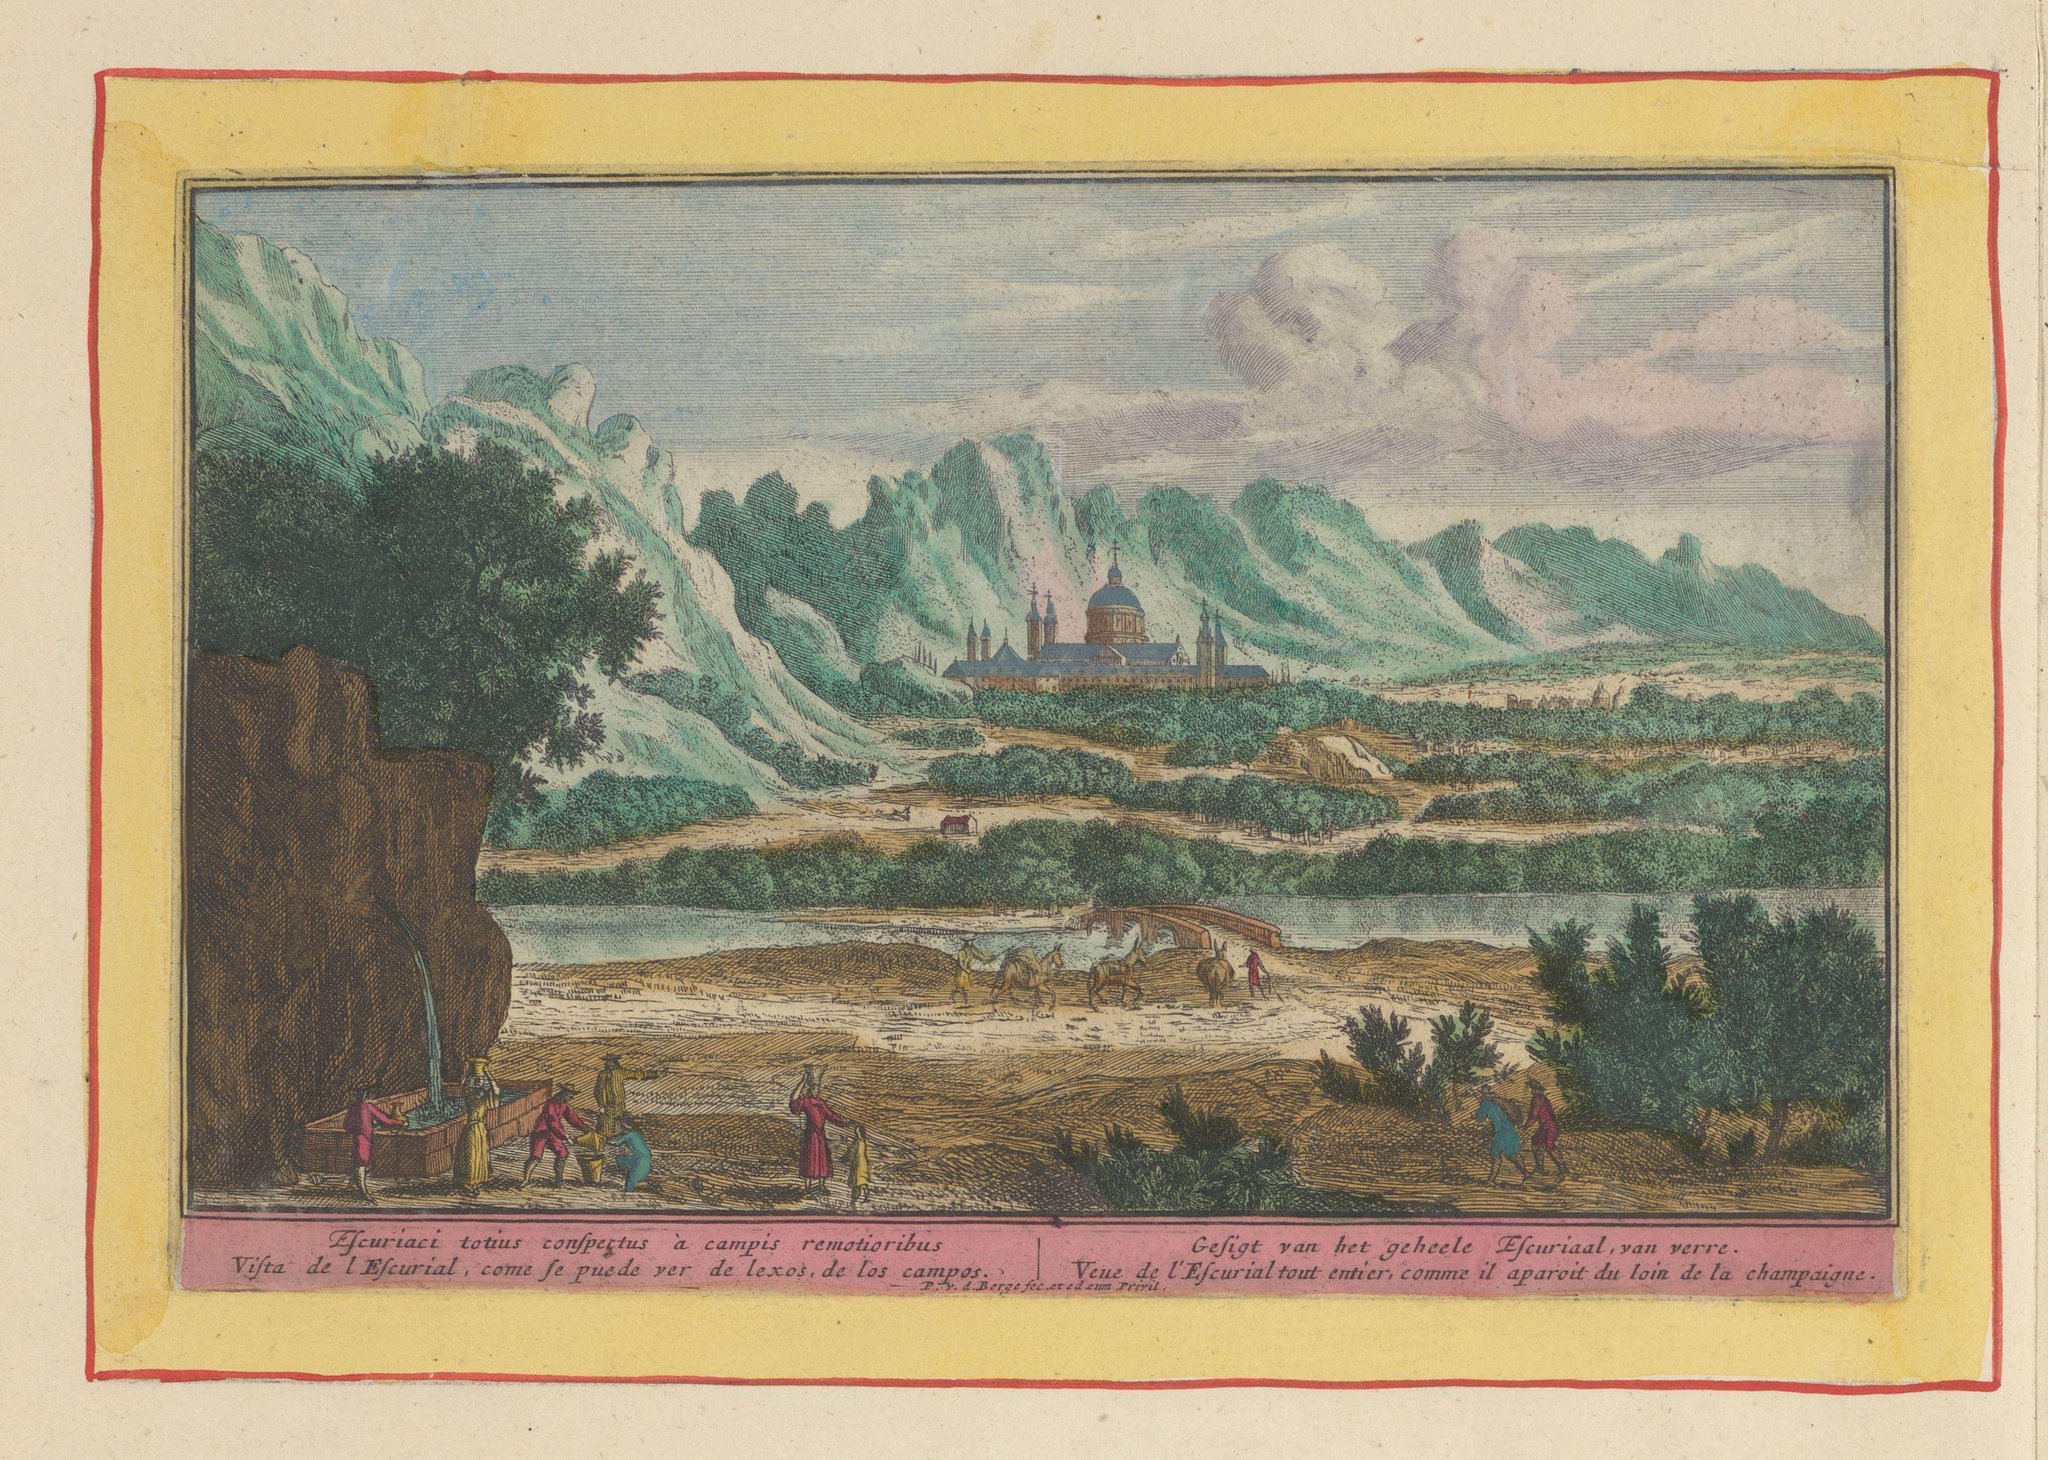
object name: print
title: Landschap met Escorial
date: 1694-1737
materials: paper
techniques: etching, hand coloring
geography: amsterdam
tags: landscapes in the temperate zone, palace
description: Prent uit: Theatrum Hispaniæ, exhibens regni urbes, villas ac viridaria magis illustria. Het aanmerkelykste en voortreffelykste in Spanjen (...). Amsterdam: Pieter van den Berge, ca. 1694-1737.